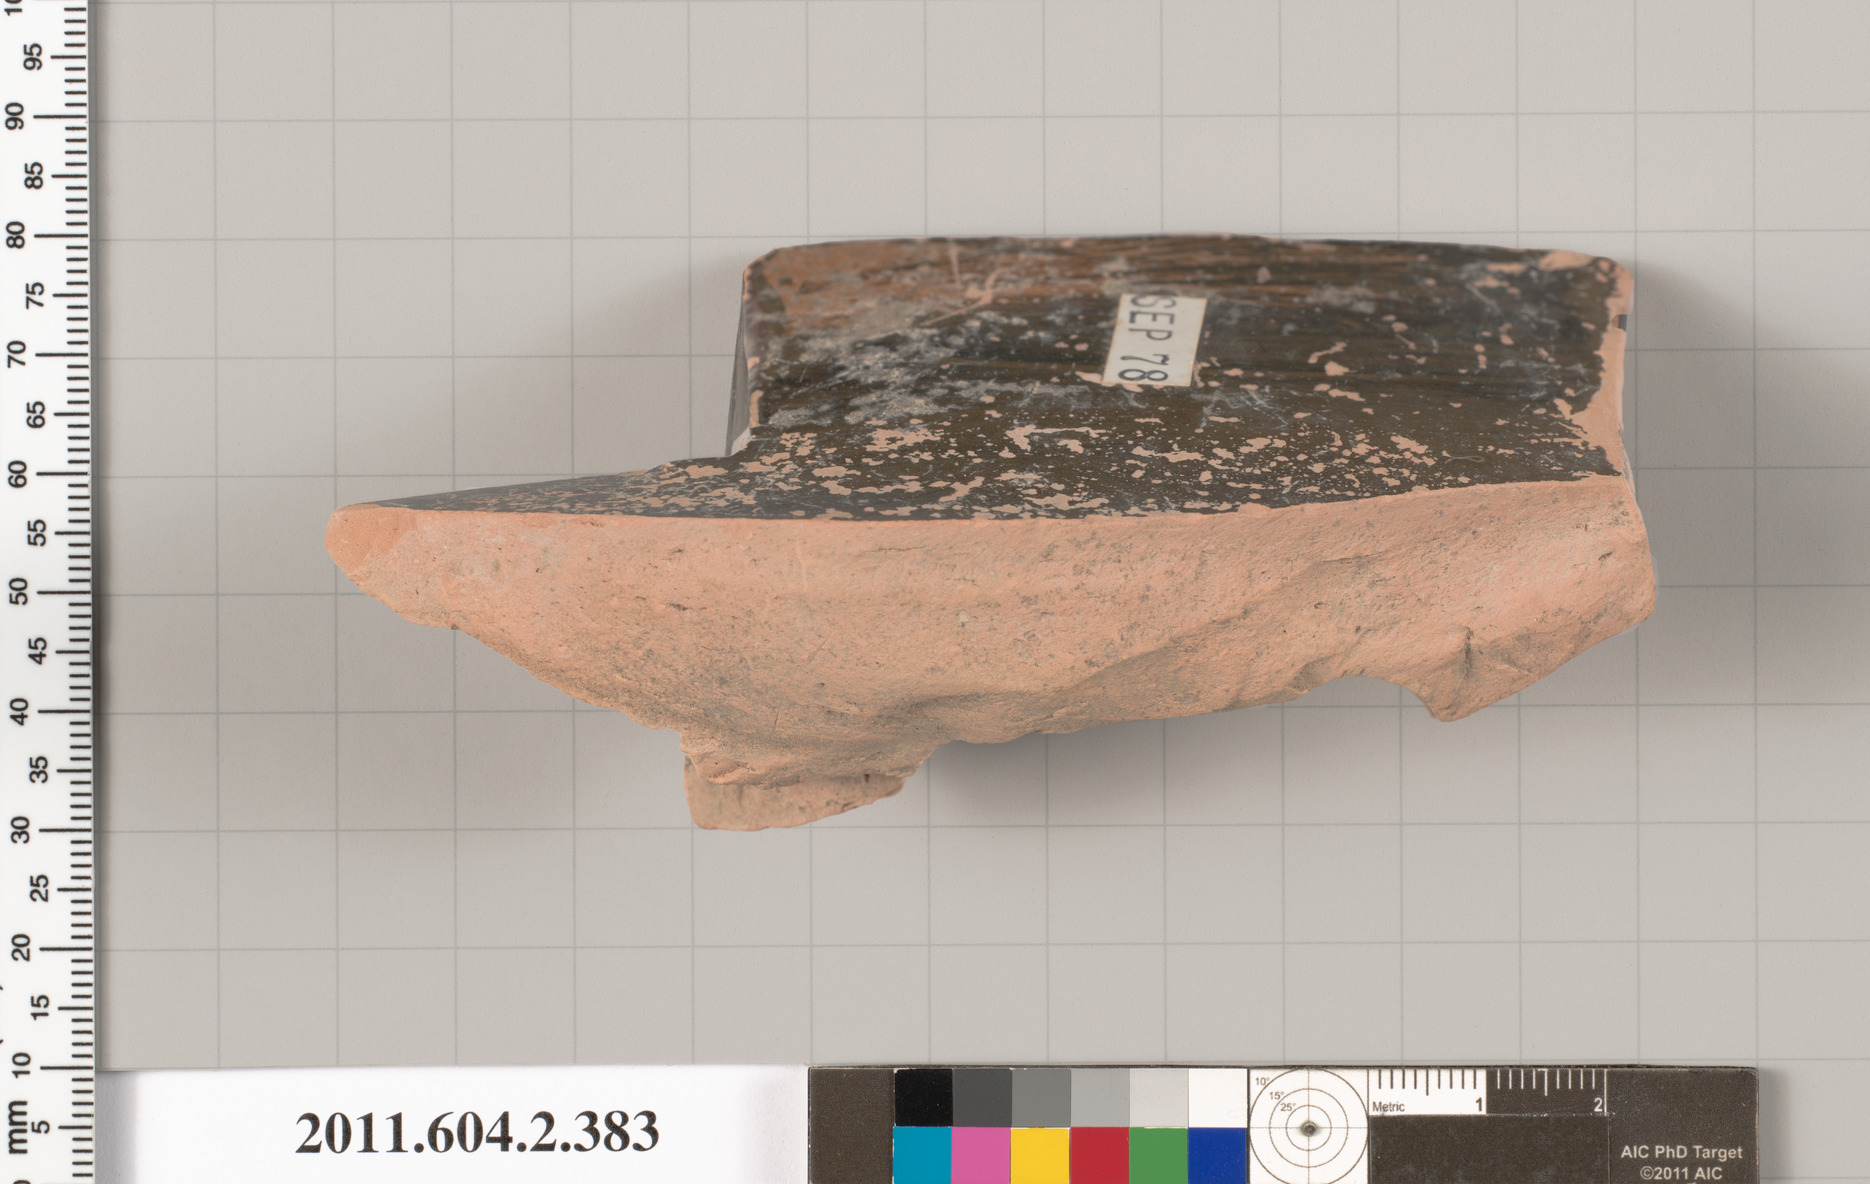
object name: column krater fragment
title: Terracotta fragment of a column-krater (bowl for mixing wine and water)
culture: greek, attic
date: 467-435 BCE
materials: terracotta